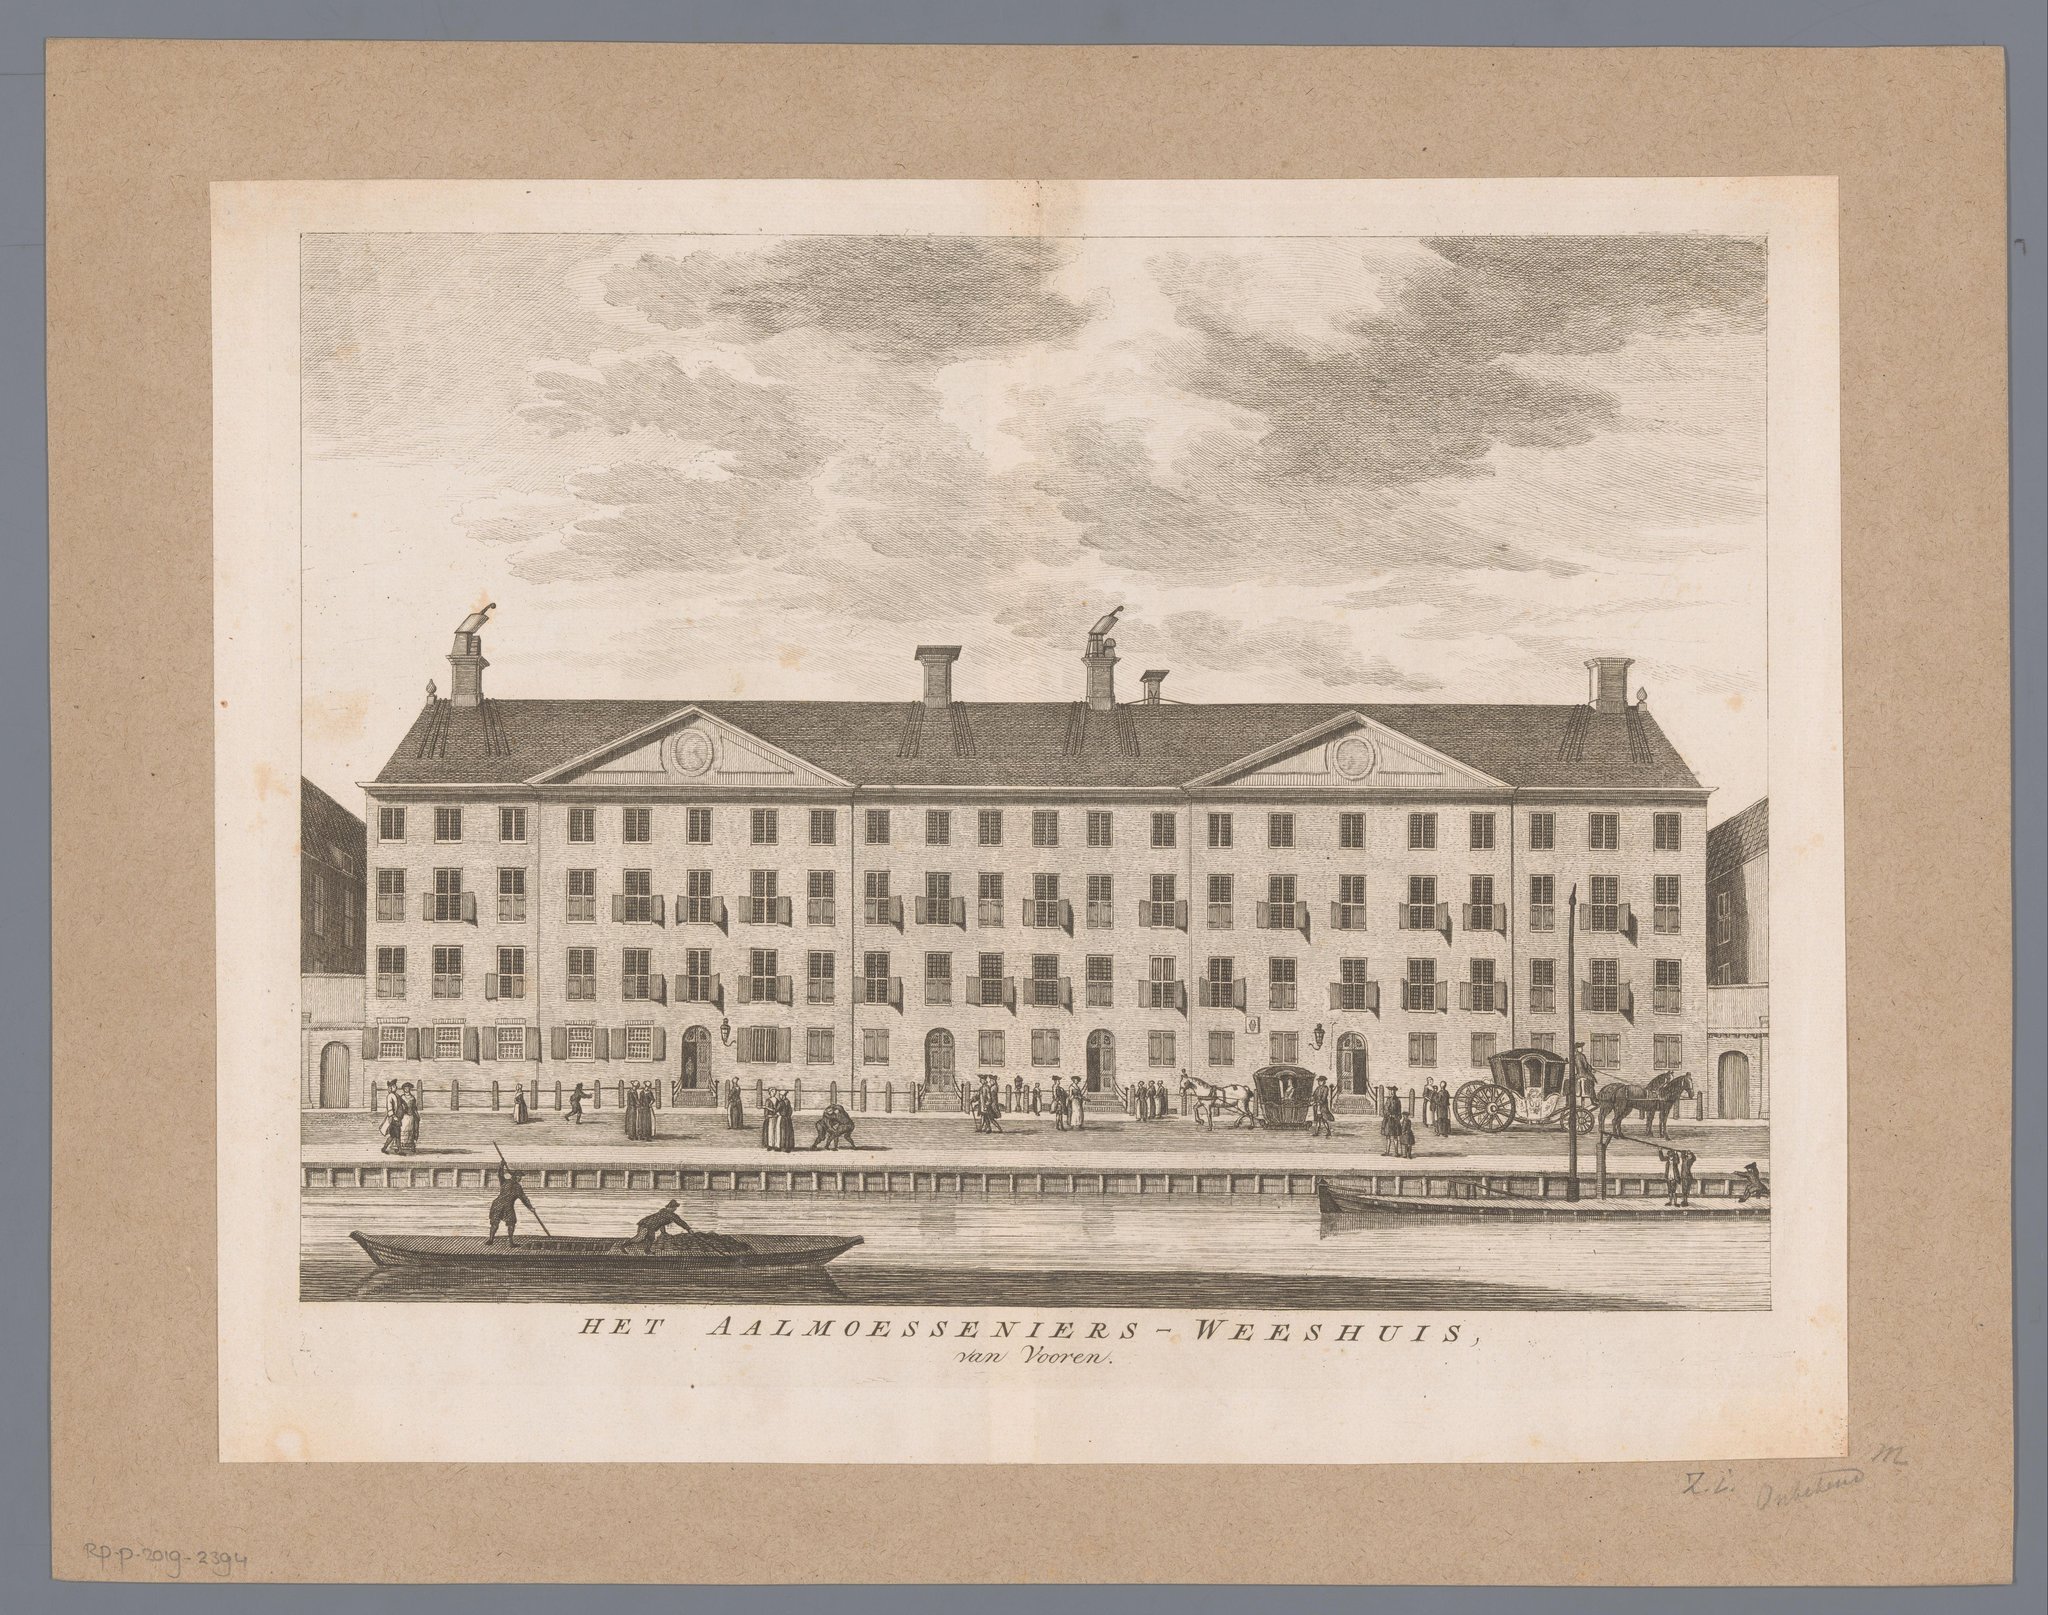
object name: book illustration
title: Gezicht op het Aalmoezeniersweeshuis in Amsterdam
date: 1760-1767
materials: paper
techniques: engraving, etching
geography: amsterdam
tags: orphanage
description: Prent uit: Wagenaar, Jan. Amsterdam, in zyne opkomst, aanwas, geschiedenissen, enz. 3 dln. Amsterdam: Isaak Tirion, 1760-1767.